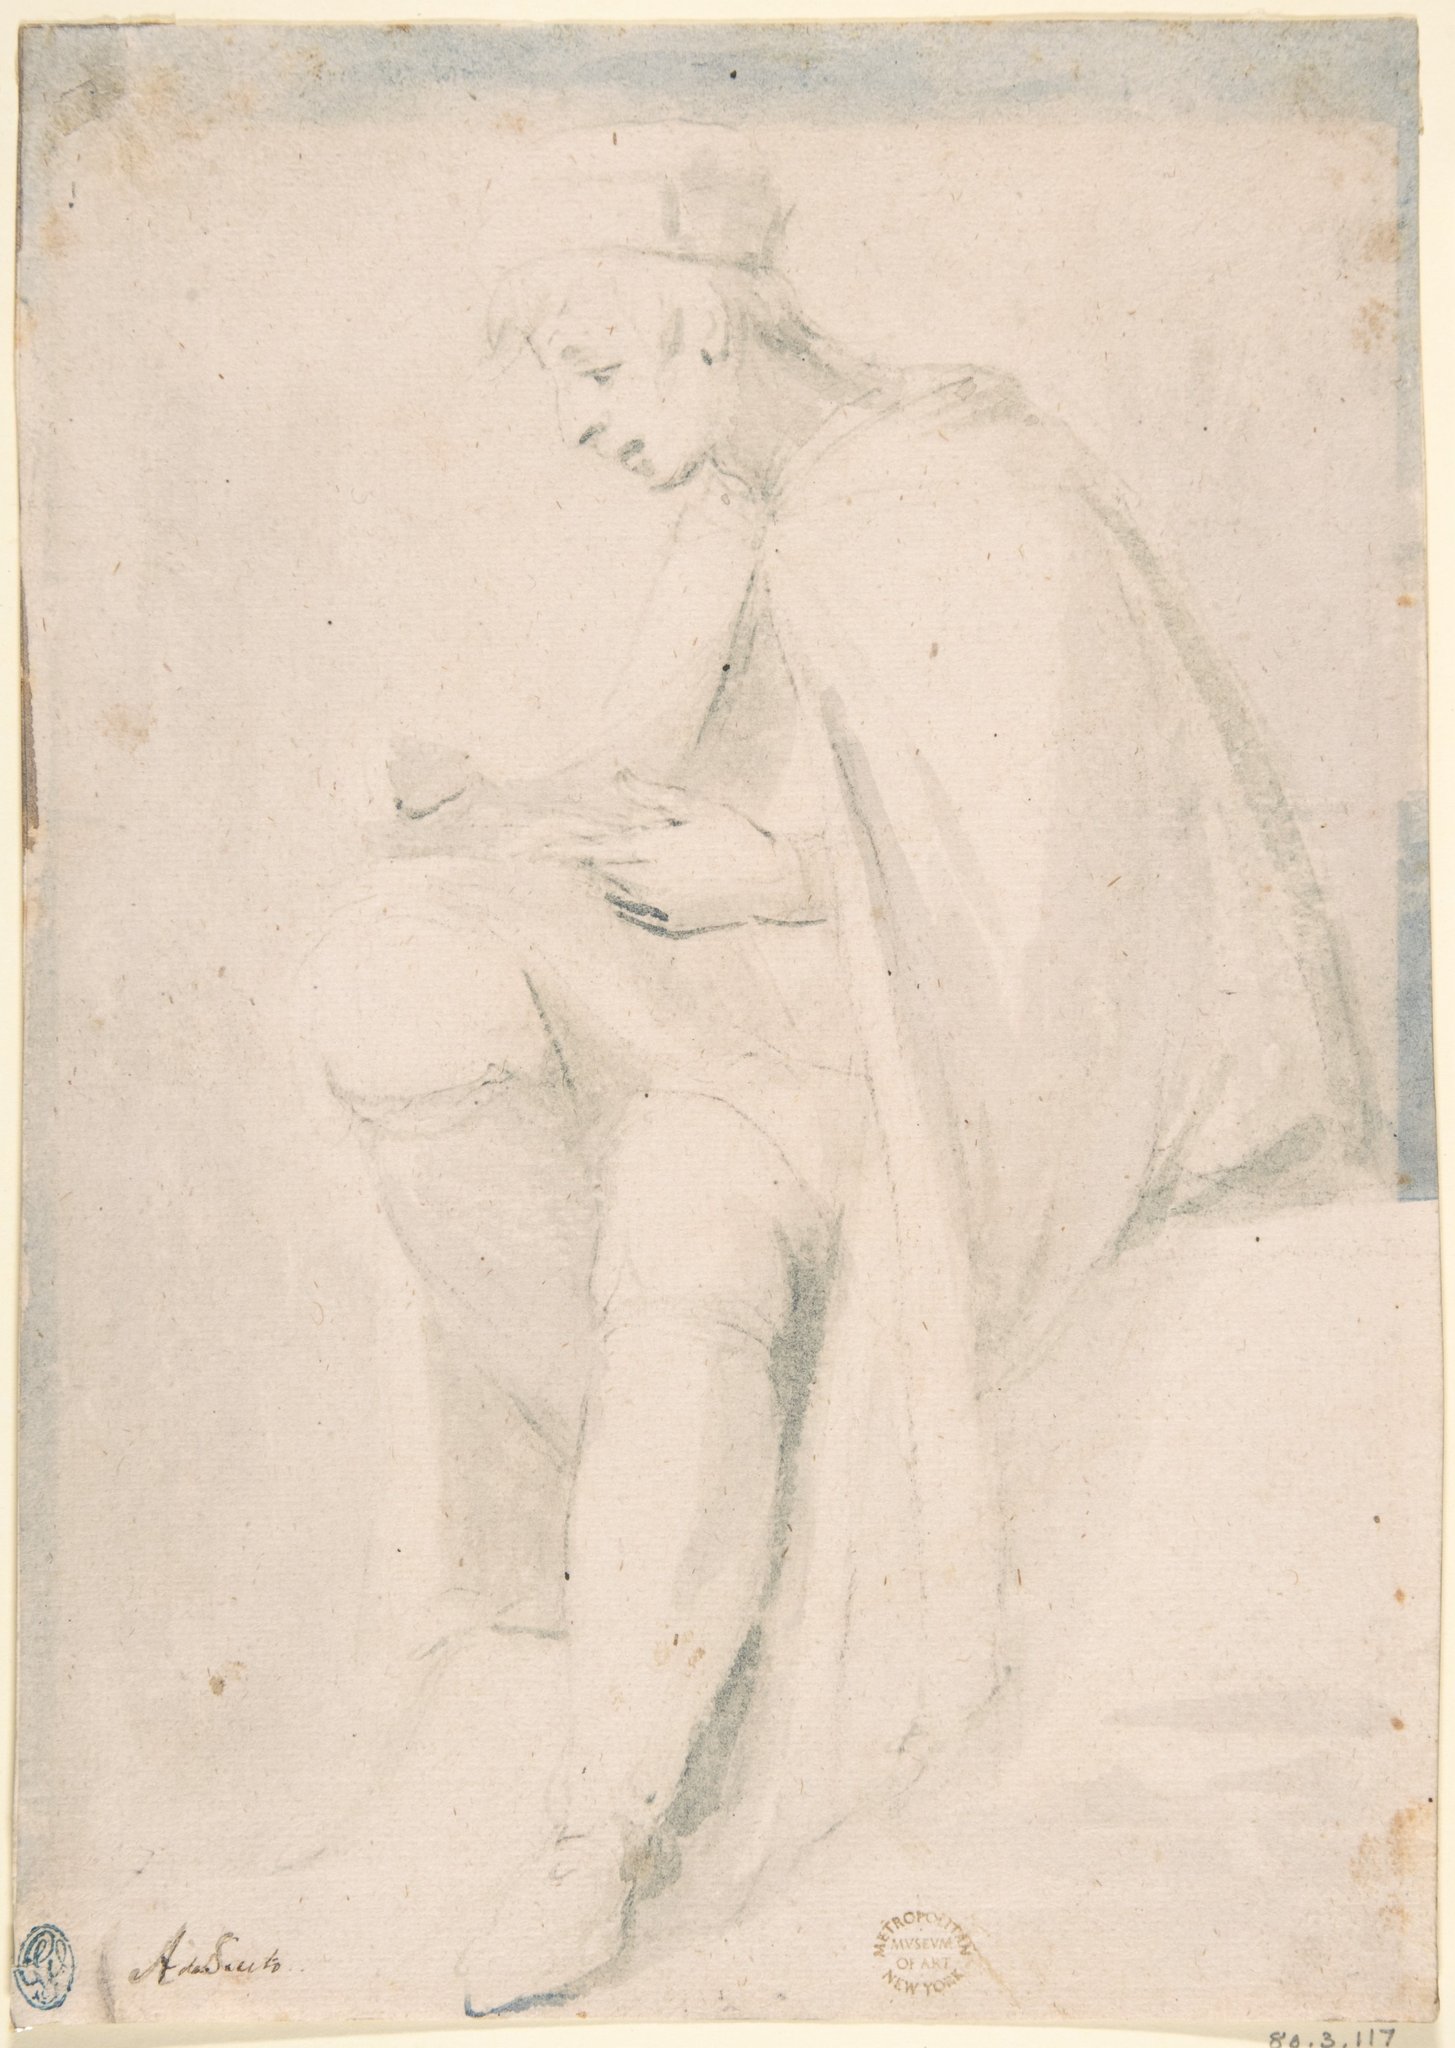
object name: drawing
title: Man Seated, Writing on His Knee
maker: anonymous, italian, 16th century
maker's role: artist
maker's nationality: italian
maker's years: 1550-1600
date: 1501-1600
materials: ink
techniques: brush, pen, wash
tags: men,writing